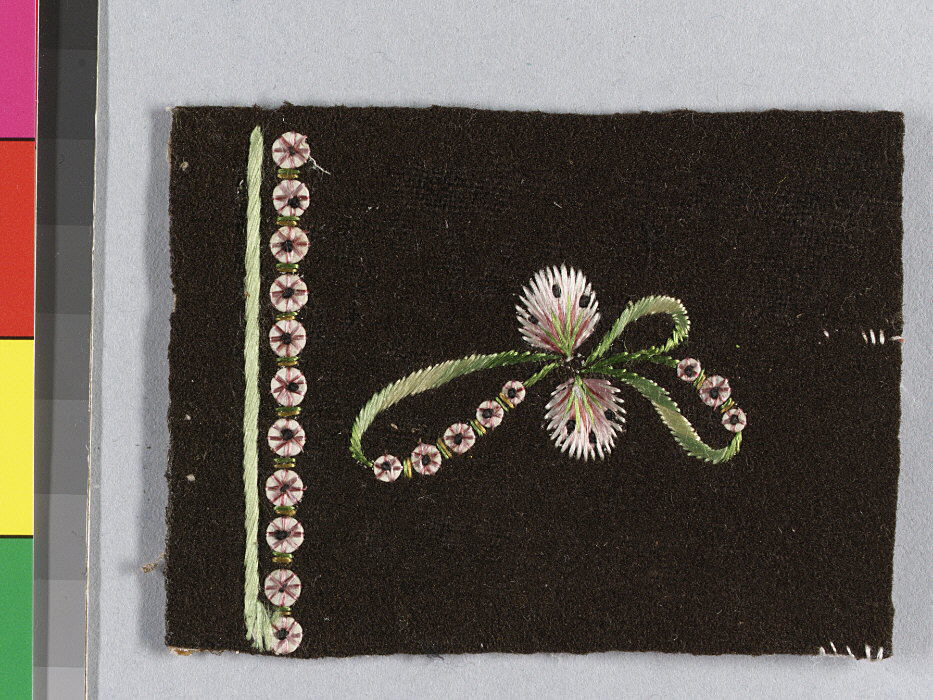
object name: sample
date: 1801-1833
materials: felt, silk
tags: flowers